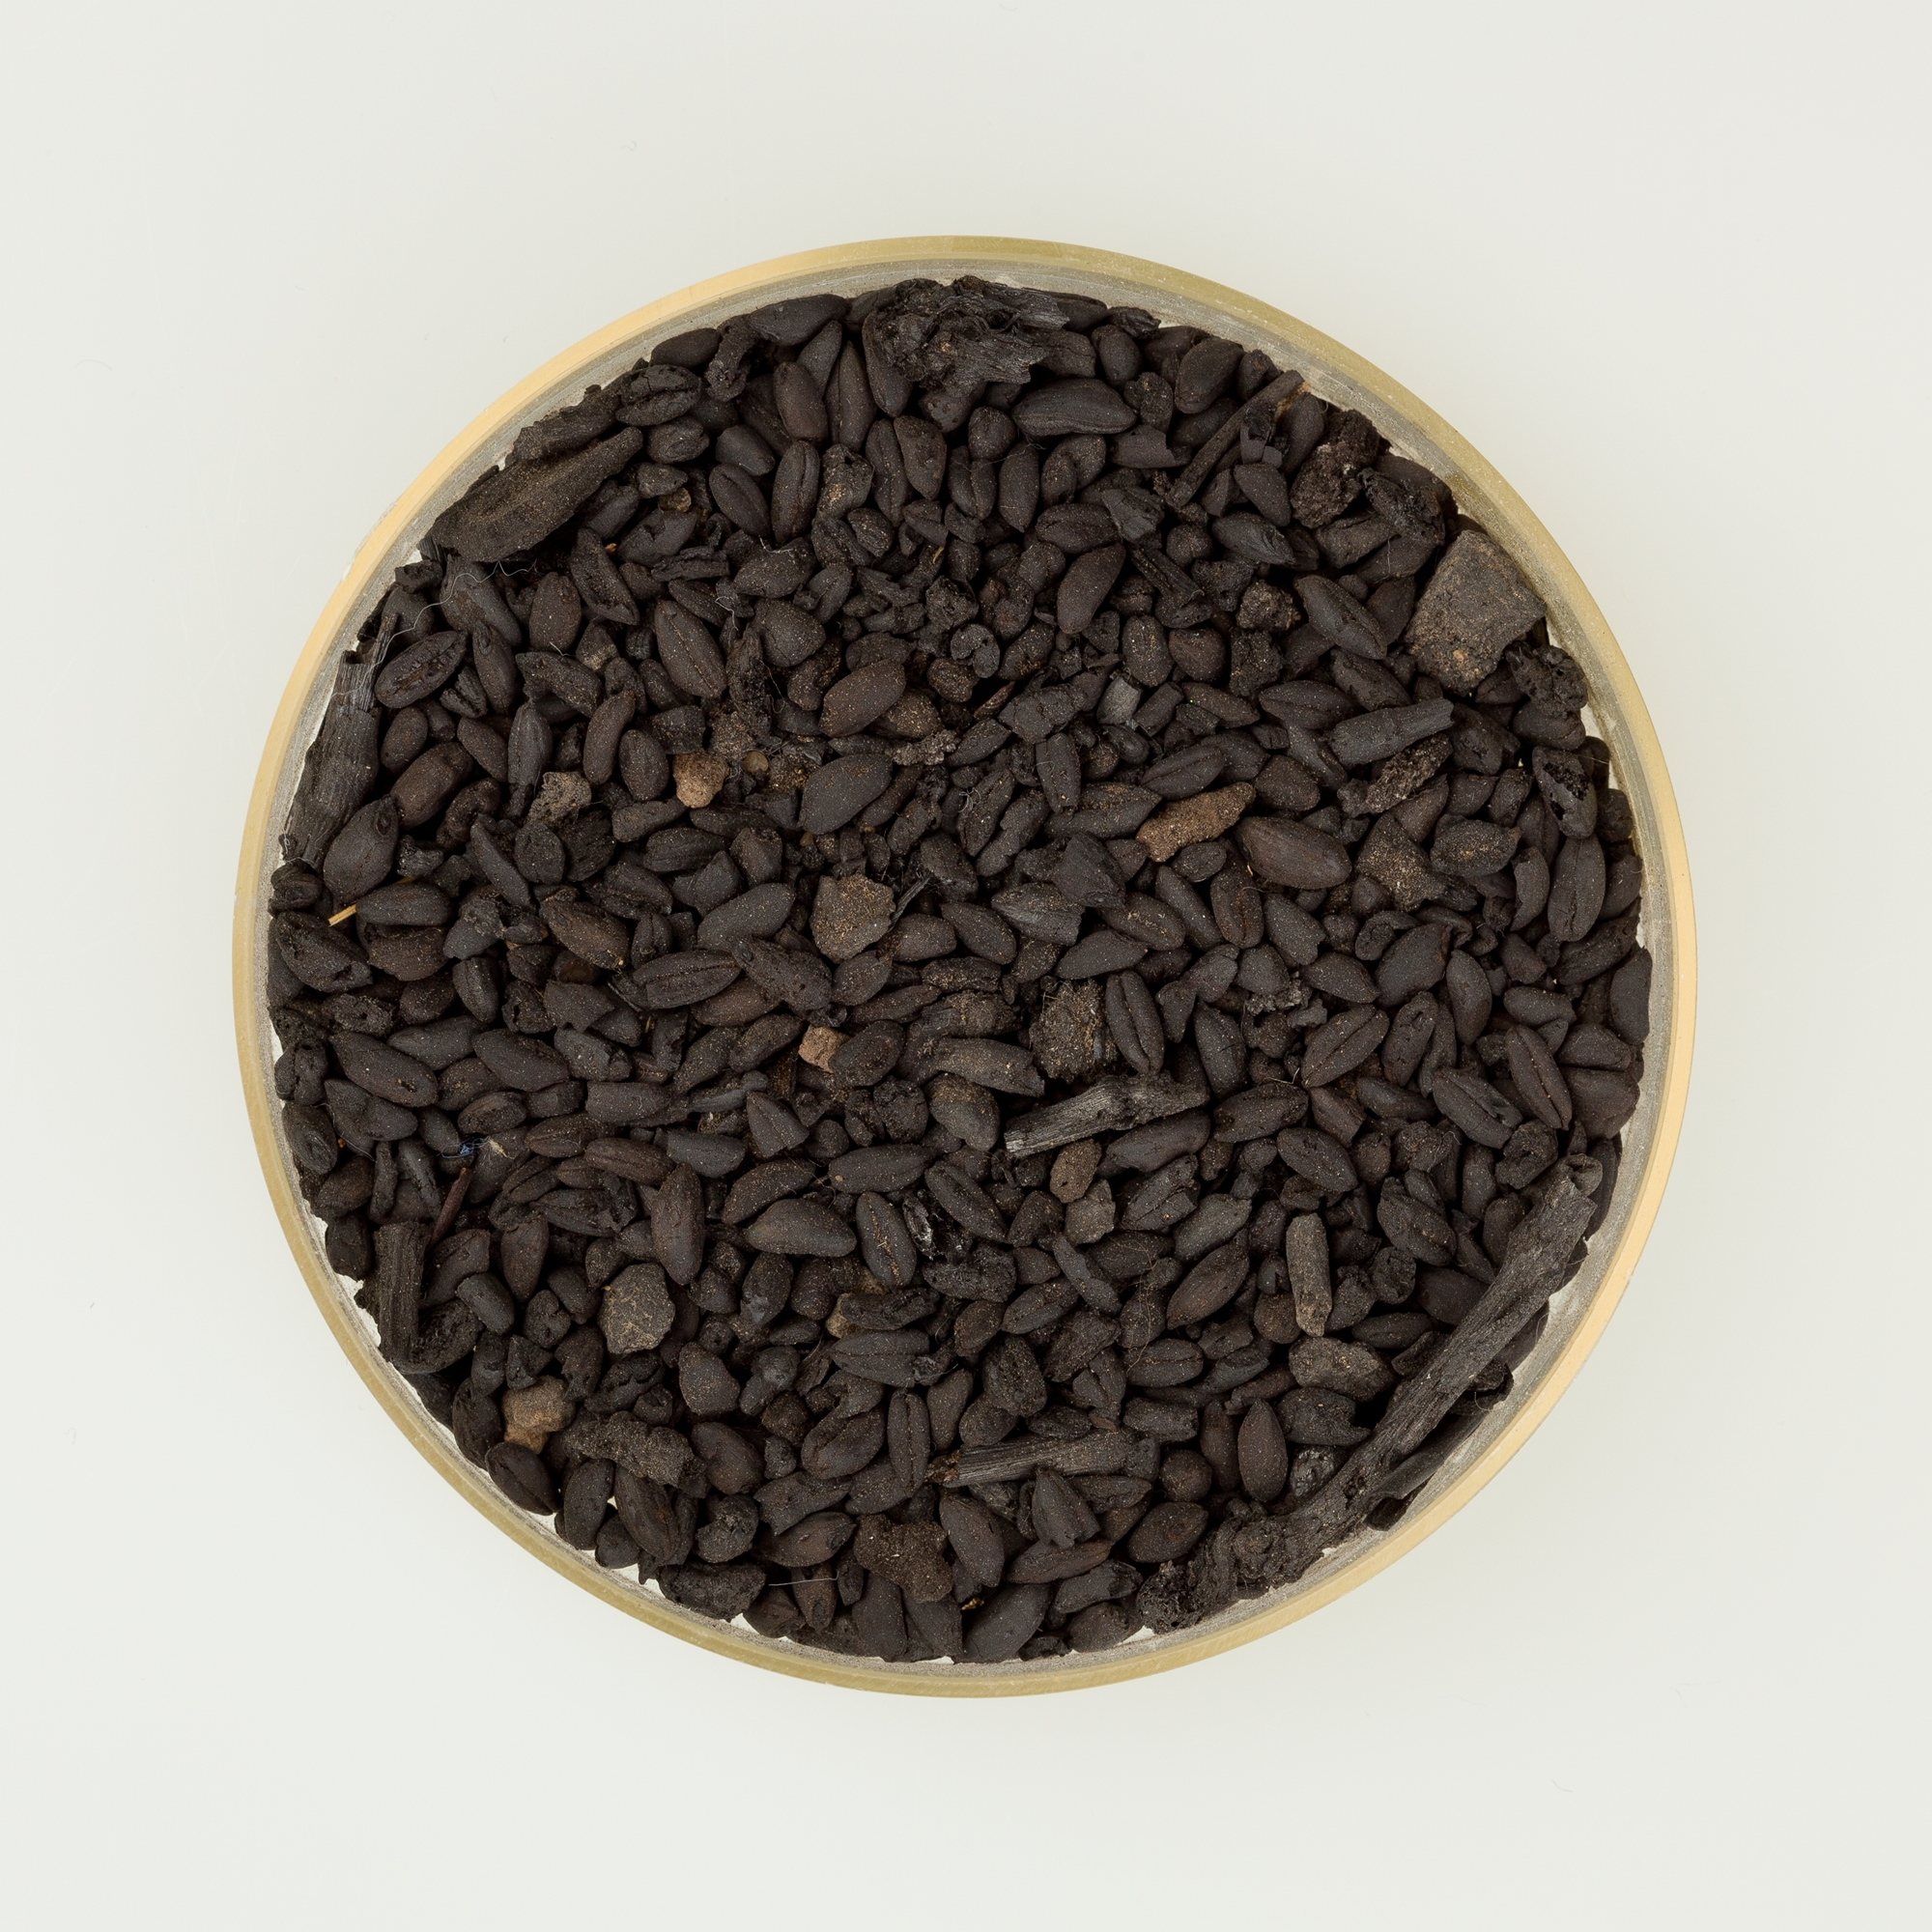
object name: food, grain, burned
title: Sample of Grain from Merimda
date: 4500-4000 BCE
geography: egypt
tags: food